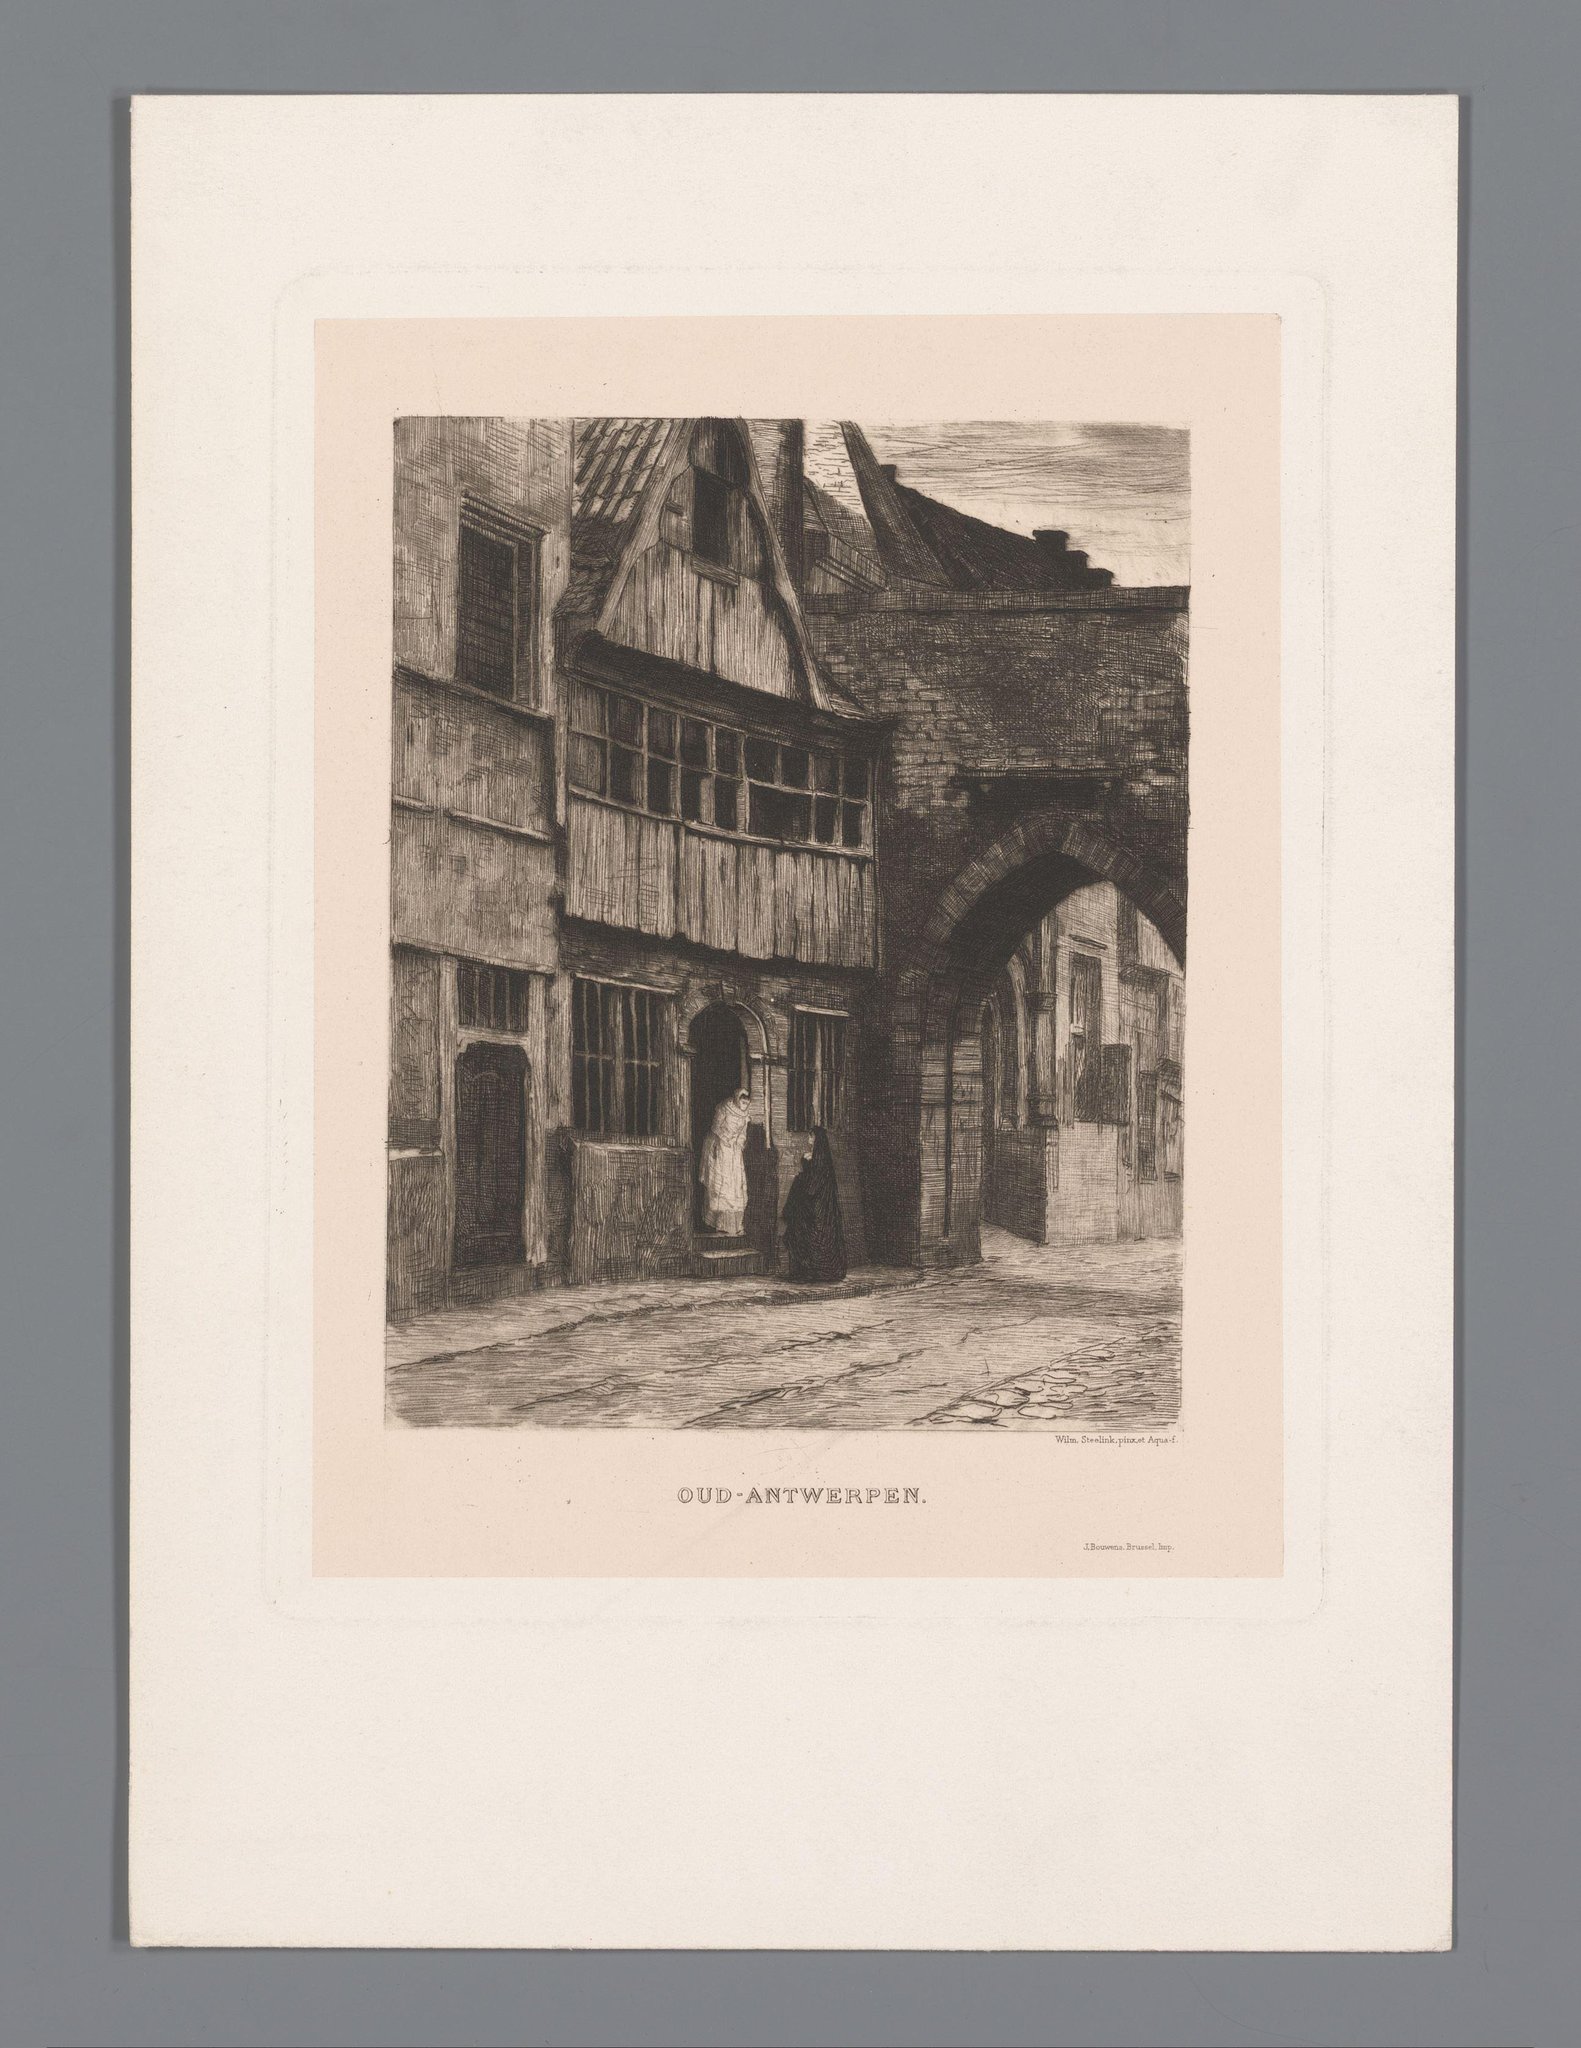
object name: print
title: Gezicht op oud Antwerpen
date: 1889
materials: paper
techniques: etching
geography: amsterdam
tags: open door, gate, entrance, antwerp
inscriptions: collector's mark: Lugt 2233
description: Een non spreekt met een vrouw, die in de deuropening van een huis staat. Rechts een poort.